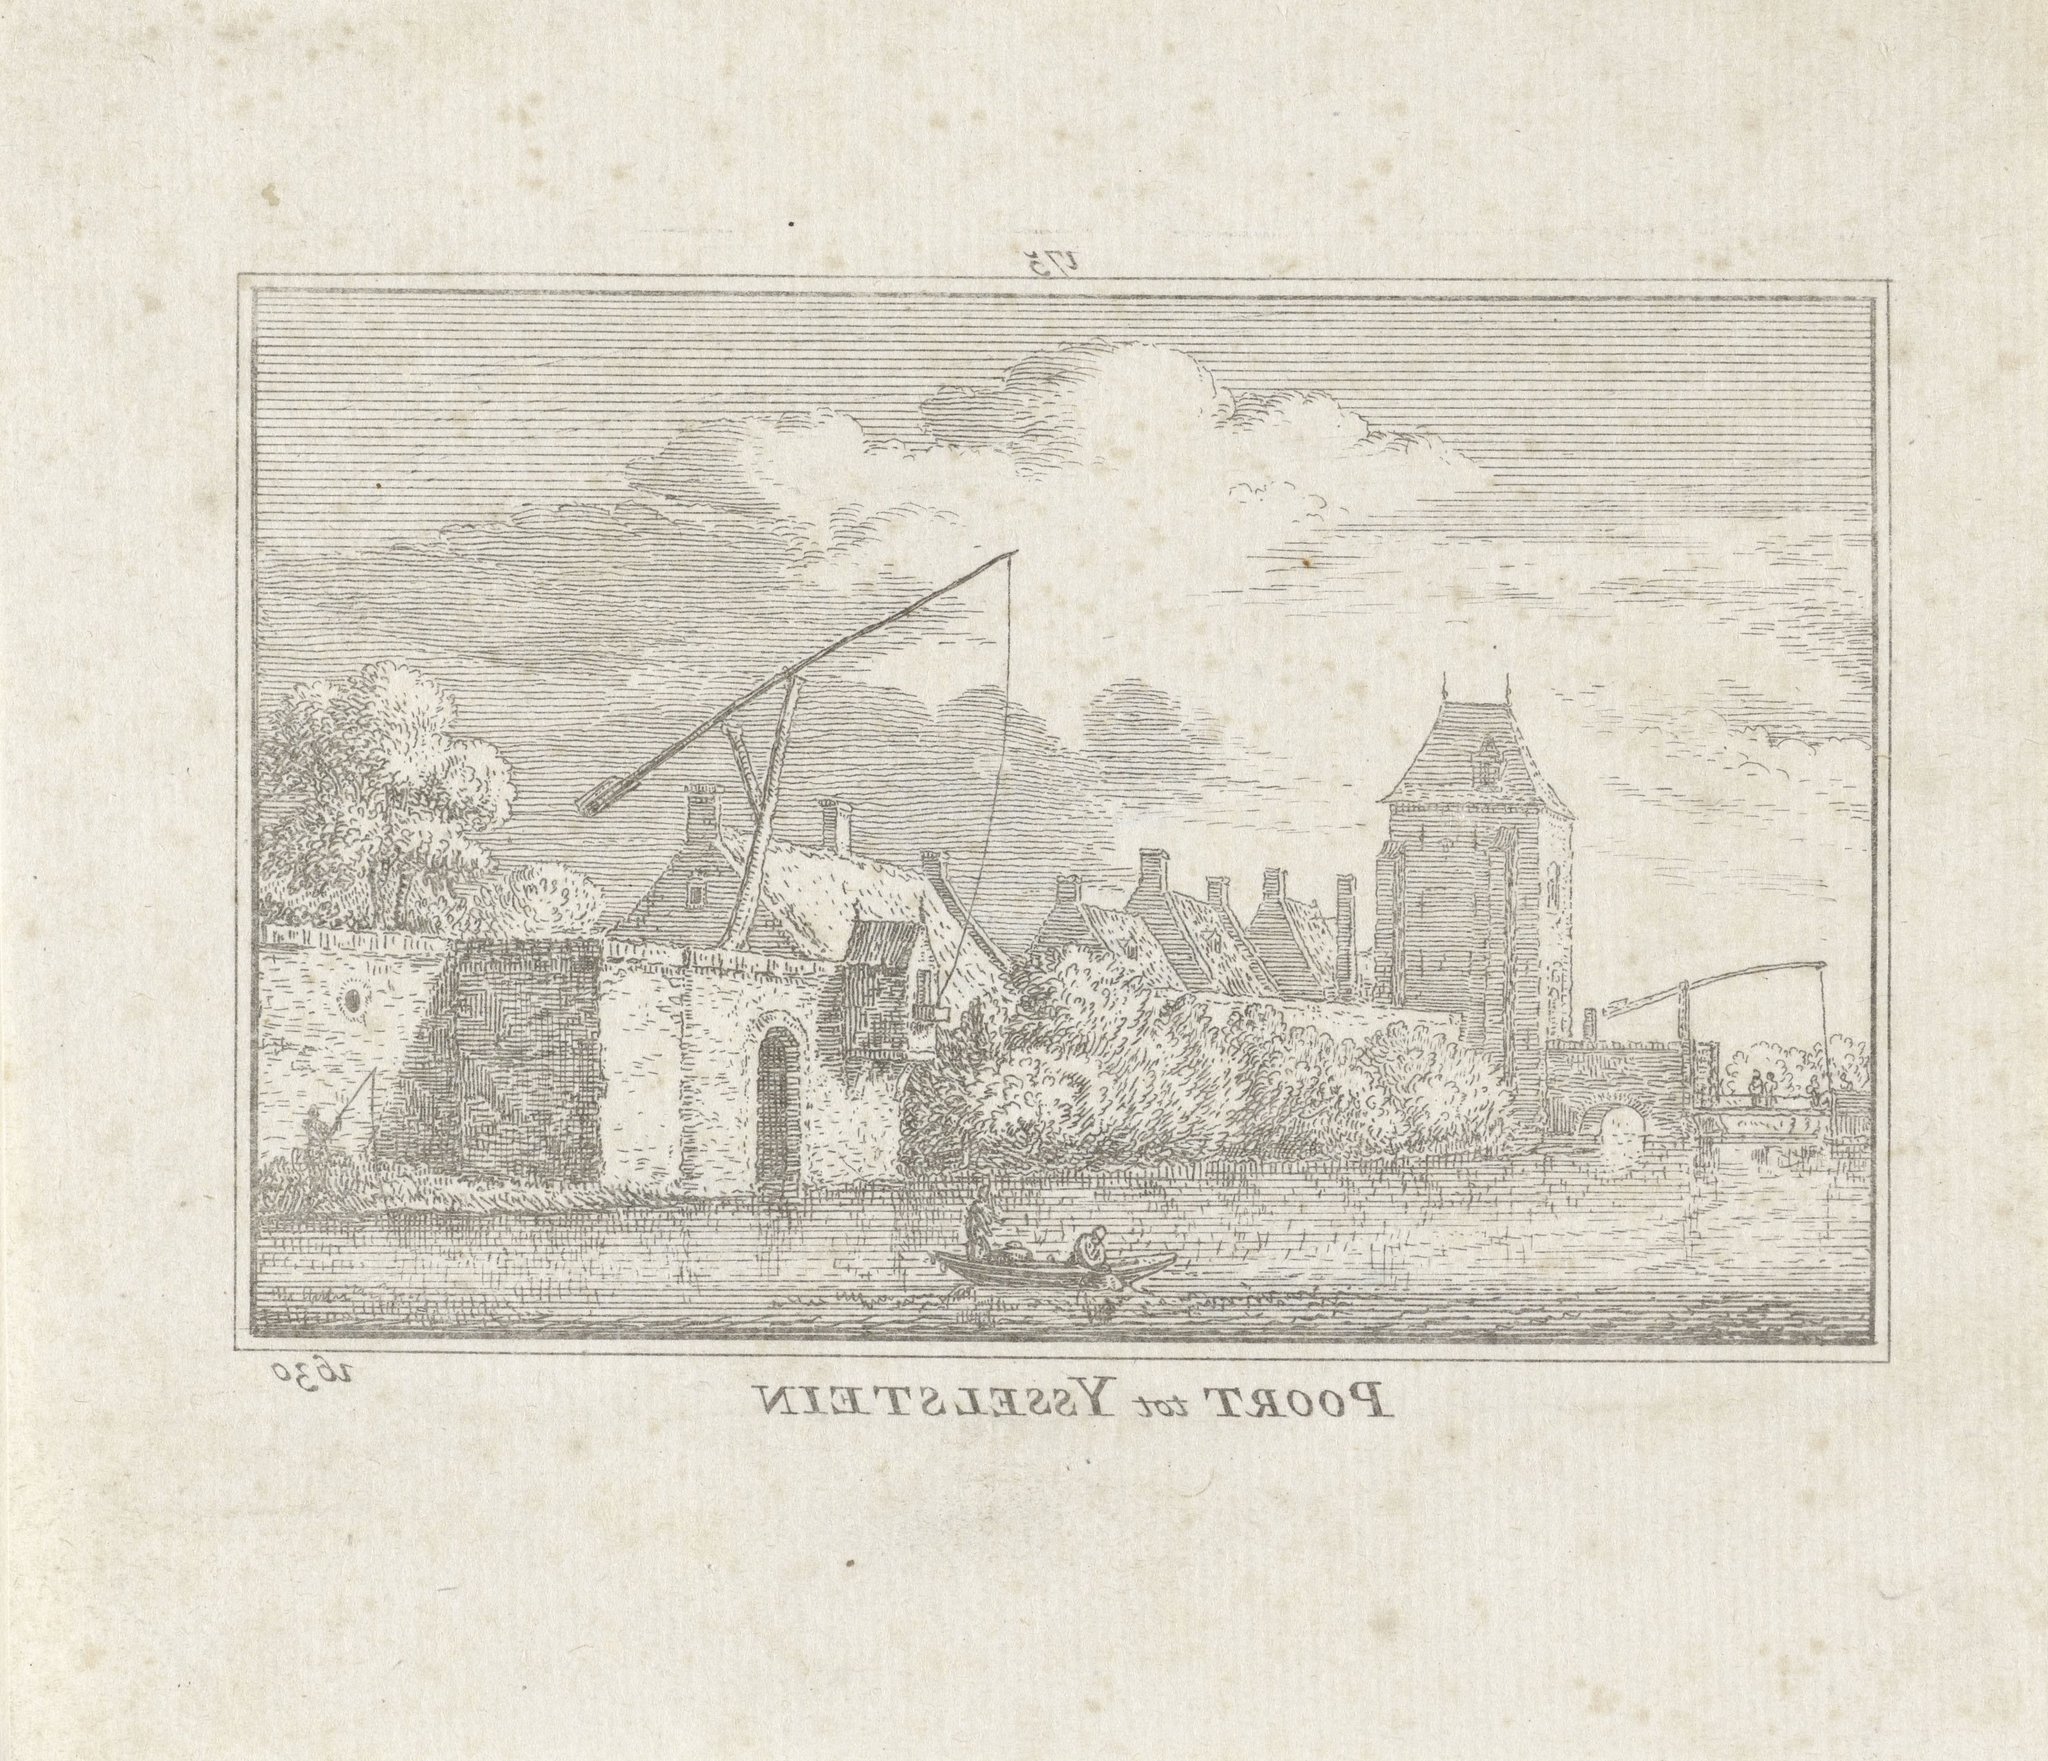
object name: print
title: Gezicht op de IJsselpoort te IJsselstein, 1630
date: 1727-1733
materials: paper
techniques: printmaking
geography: amsterdam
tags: rowing-boat, canoe, etc., bridge, city-gate, fisherman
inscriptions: collector's mark: Lugt 2228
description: Gezicht op de IJsselpoort te IJsselstein in de situatie omstreeks 1630. Links de poort en rechts een roeiboot en enkele vissers.